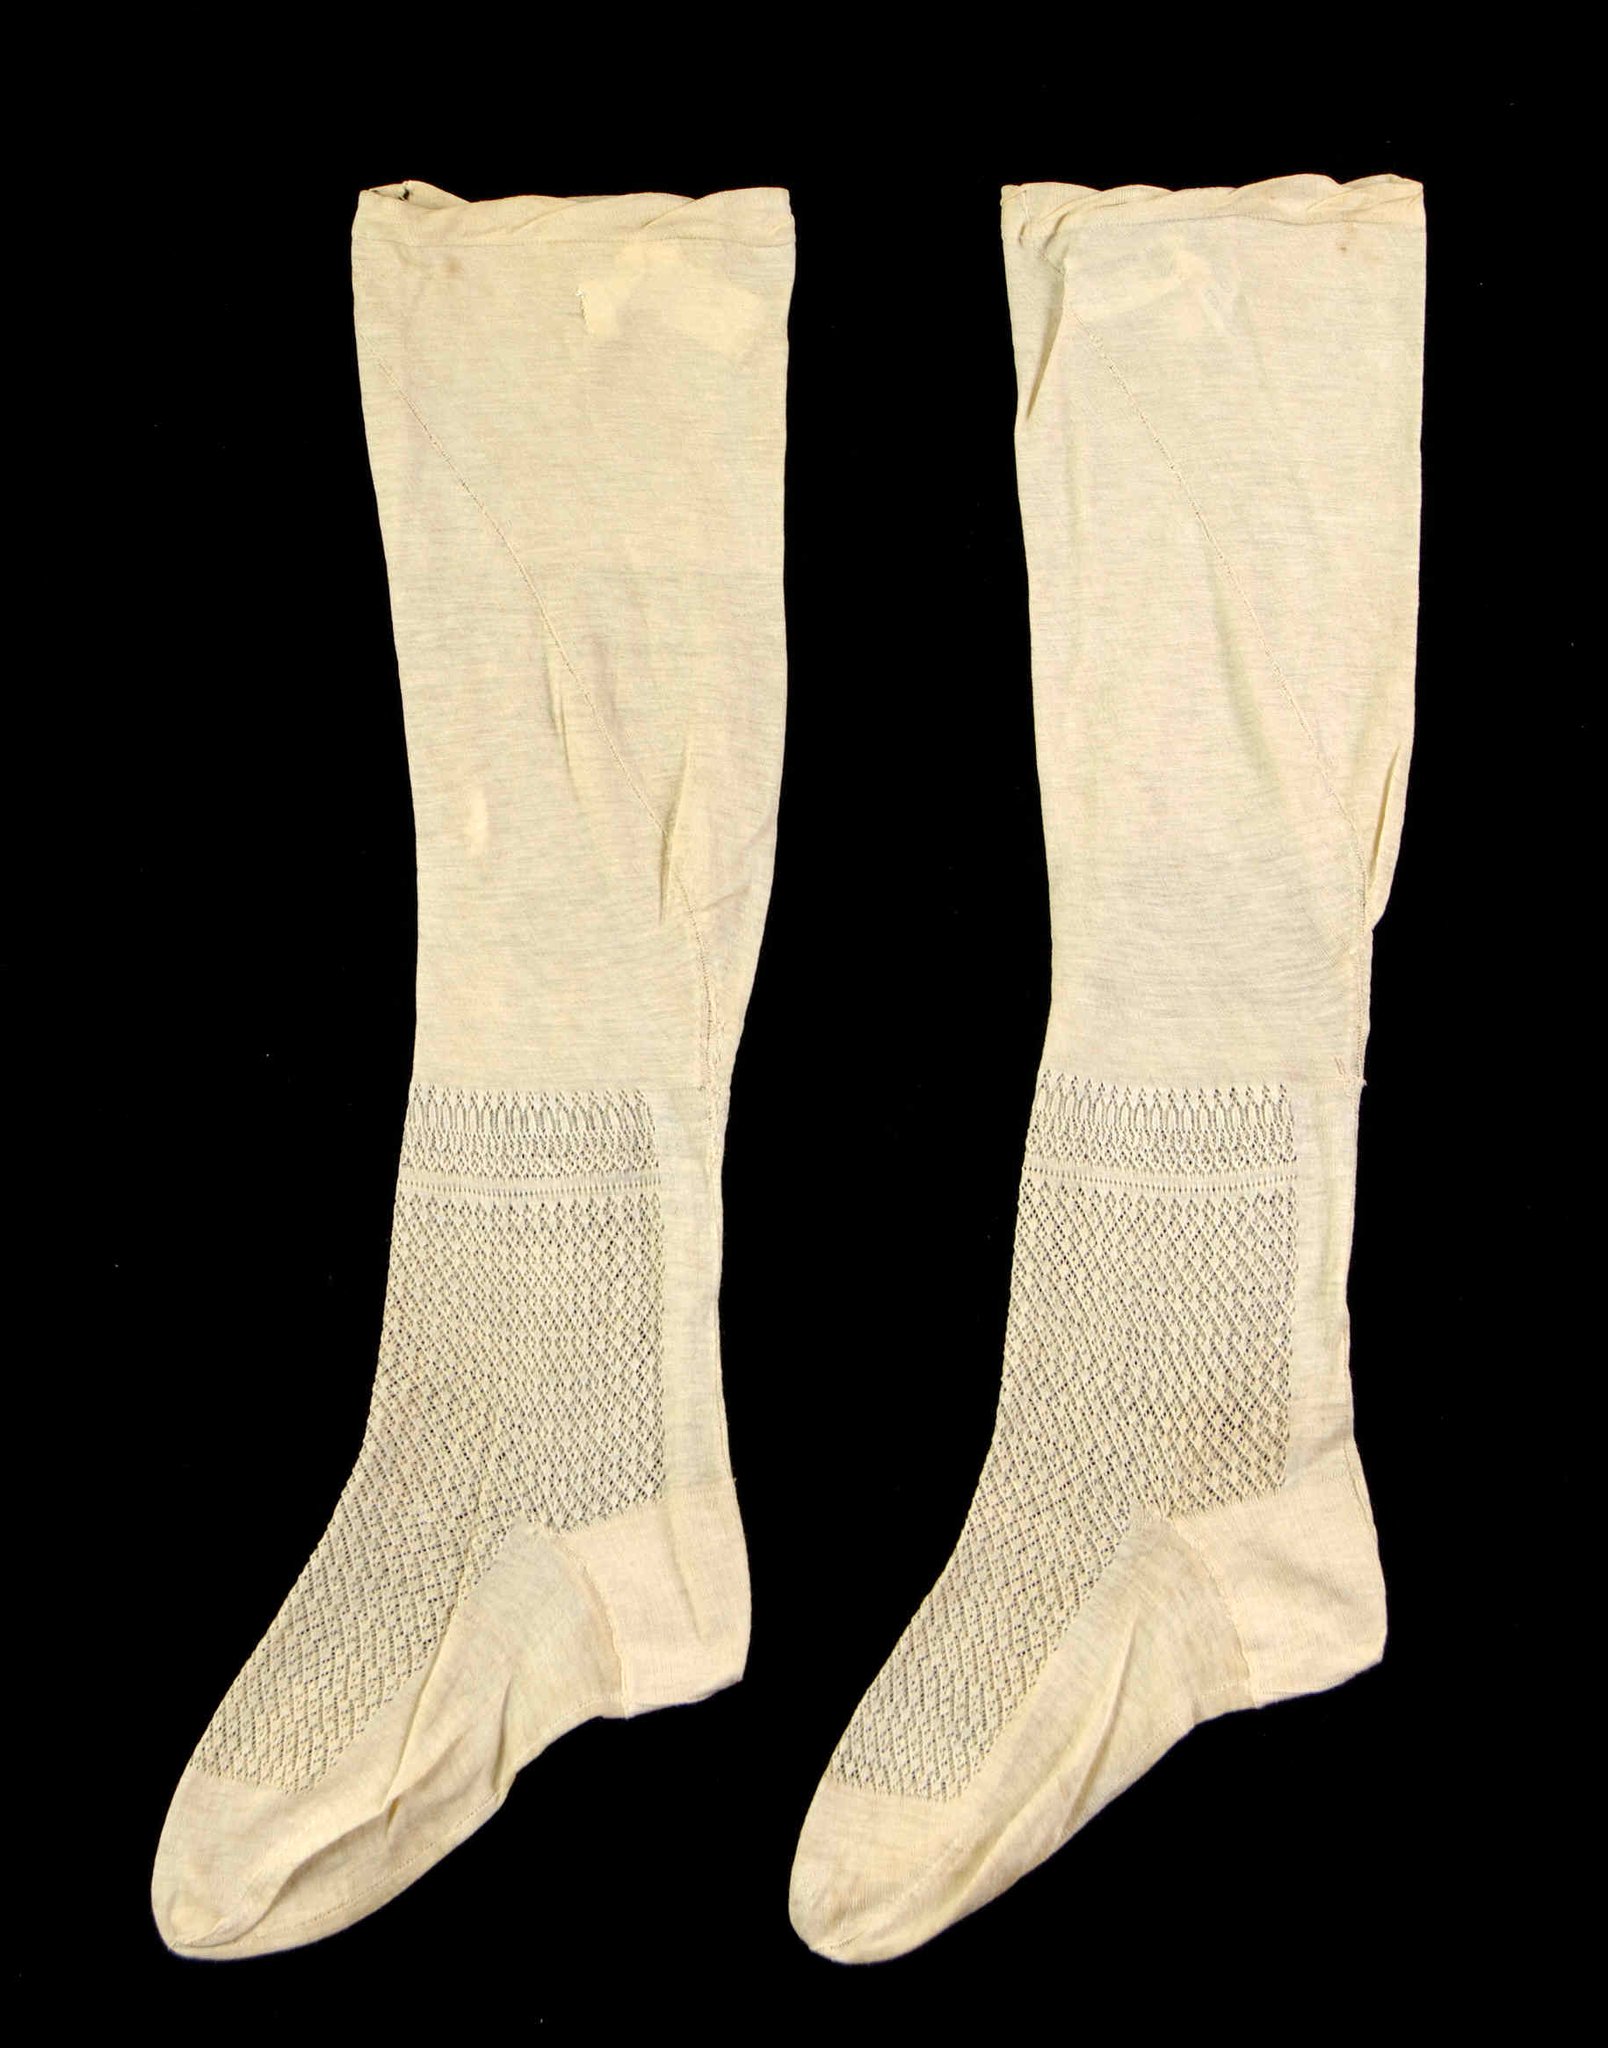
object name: stocking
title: Stockings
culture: american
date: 1850-1860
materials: cotton